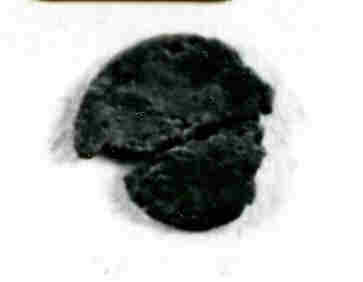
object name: coin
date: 401-1400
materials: copper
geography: iran